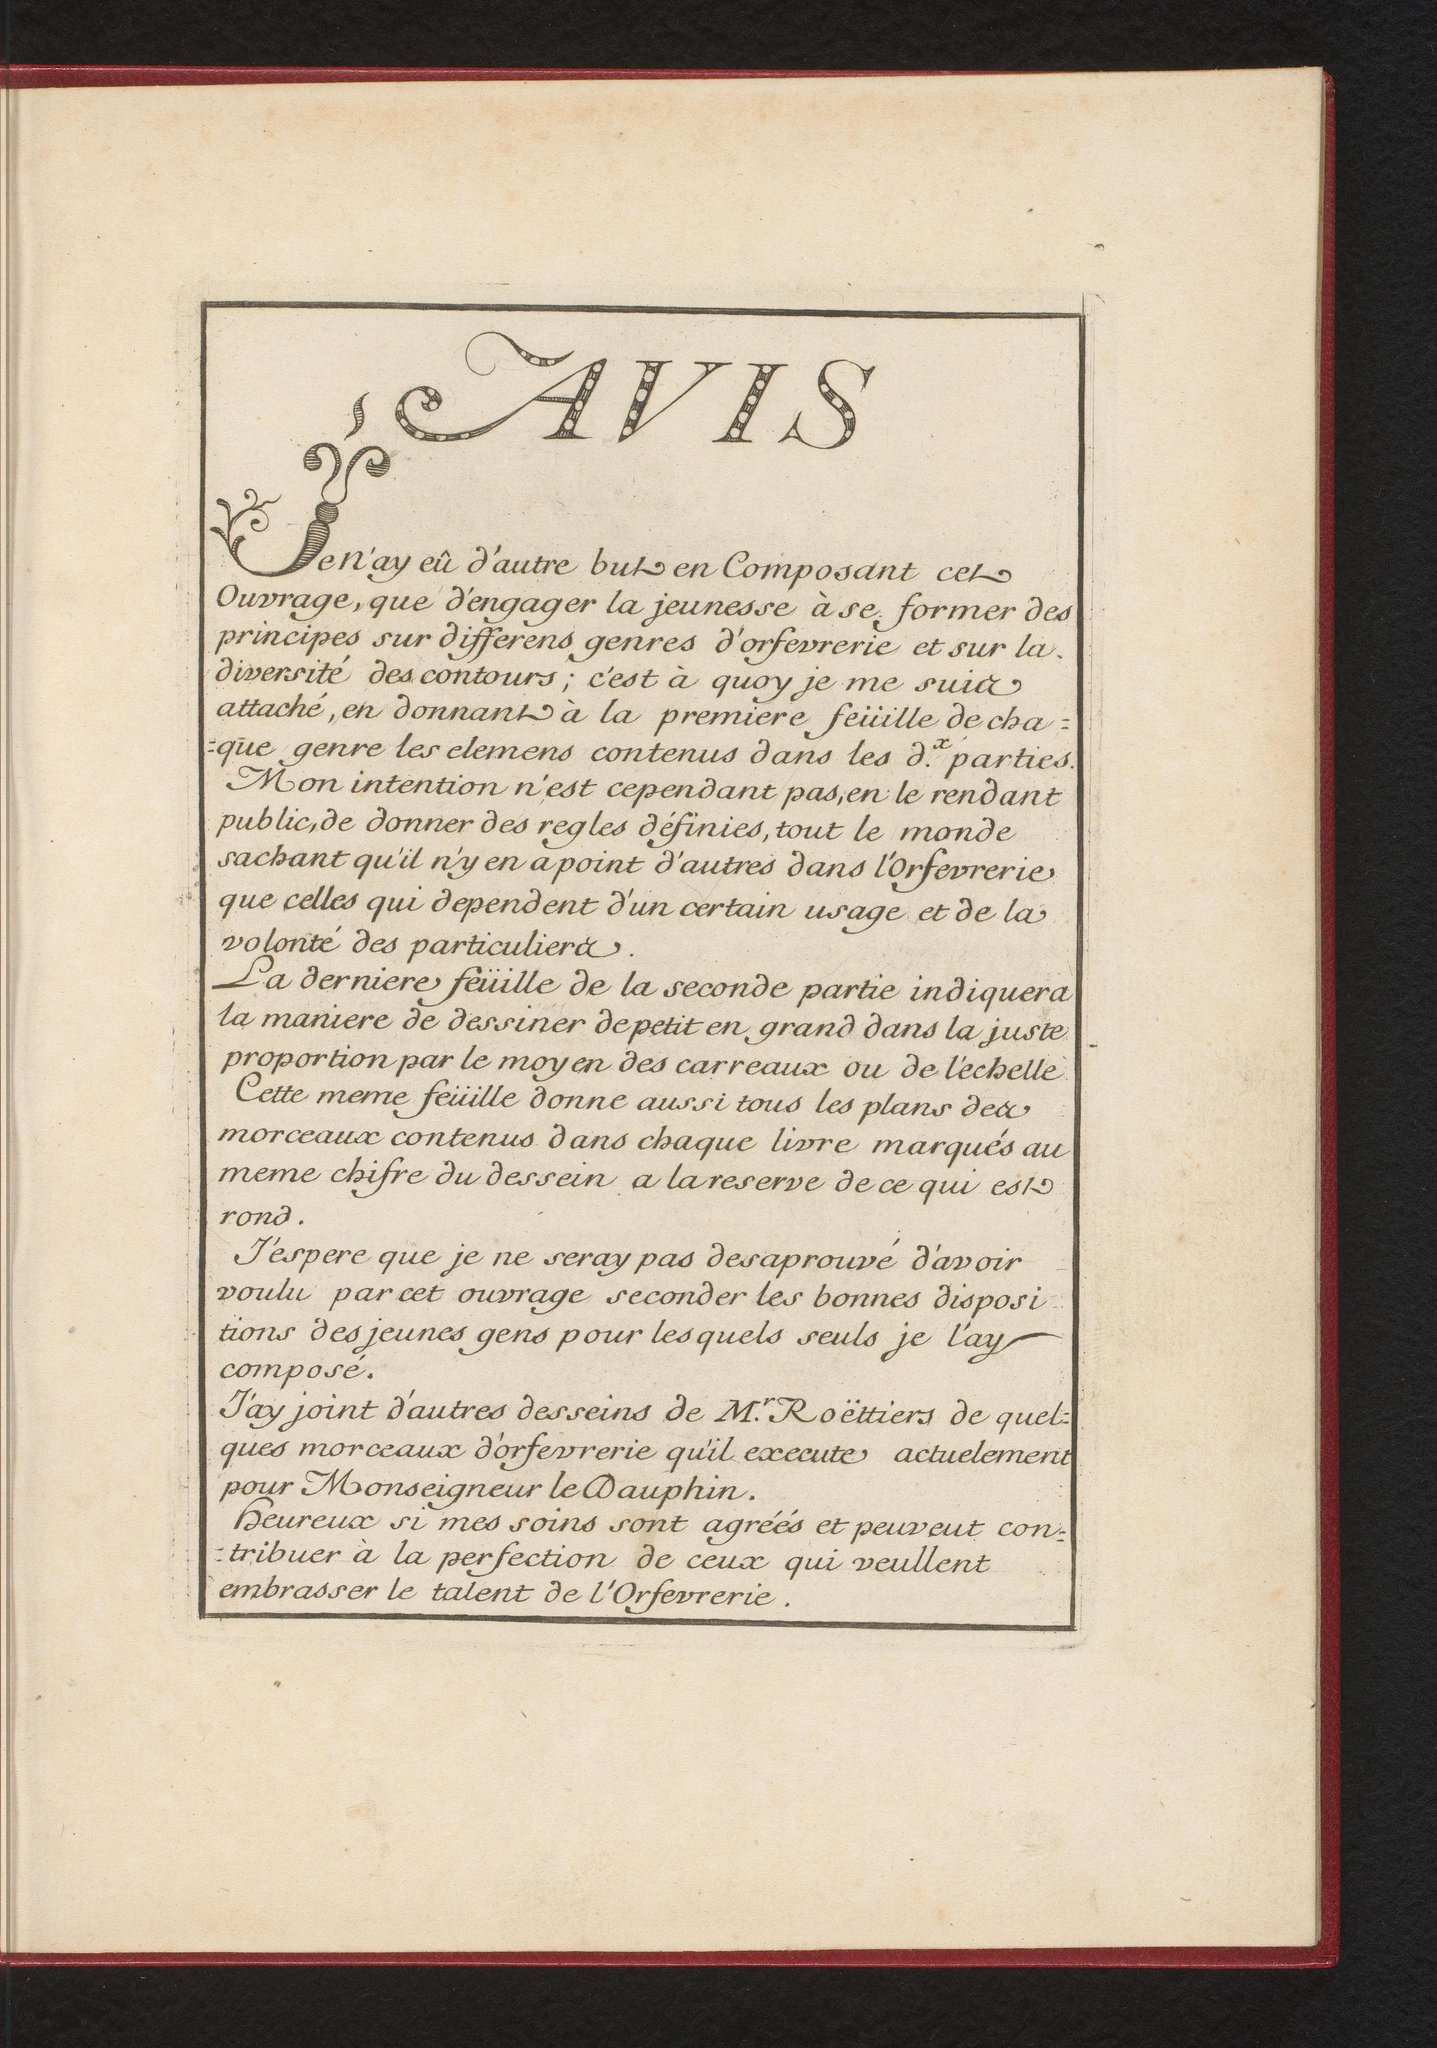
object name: print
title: Elements d'orfevrerie divisés en deux parties de cinquante feuilles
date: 1748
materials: paper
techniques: etching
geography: paris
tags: book in which illustrations are essential, letters, alphabet, script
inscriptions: date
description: Een aantal van de objecten in deze reeks heeft een eigen ondertitel, die verwijst naar genummerde 'cahiers' (afleveringen) waarin de prenten werden uitgegeven. Het is onduidelijk welke objecten recies bij welke aflevering horen. Daarom is die ondertitel enkel verwerkt bij de prent waarop die voorkomt.